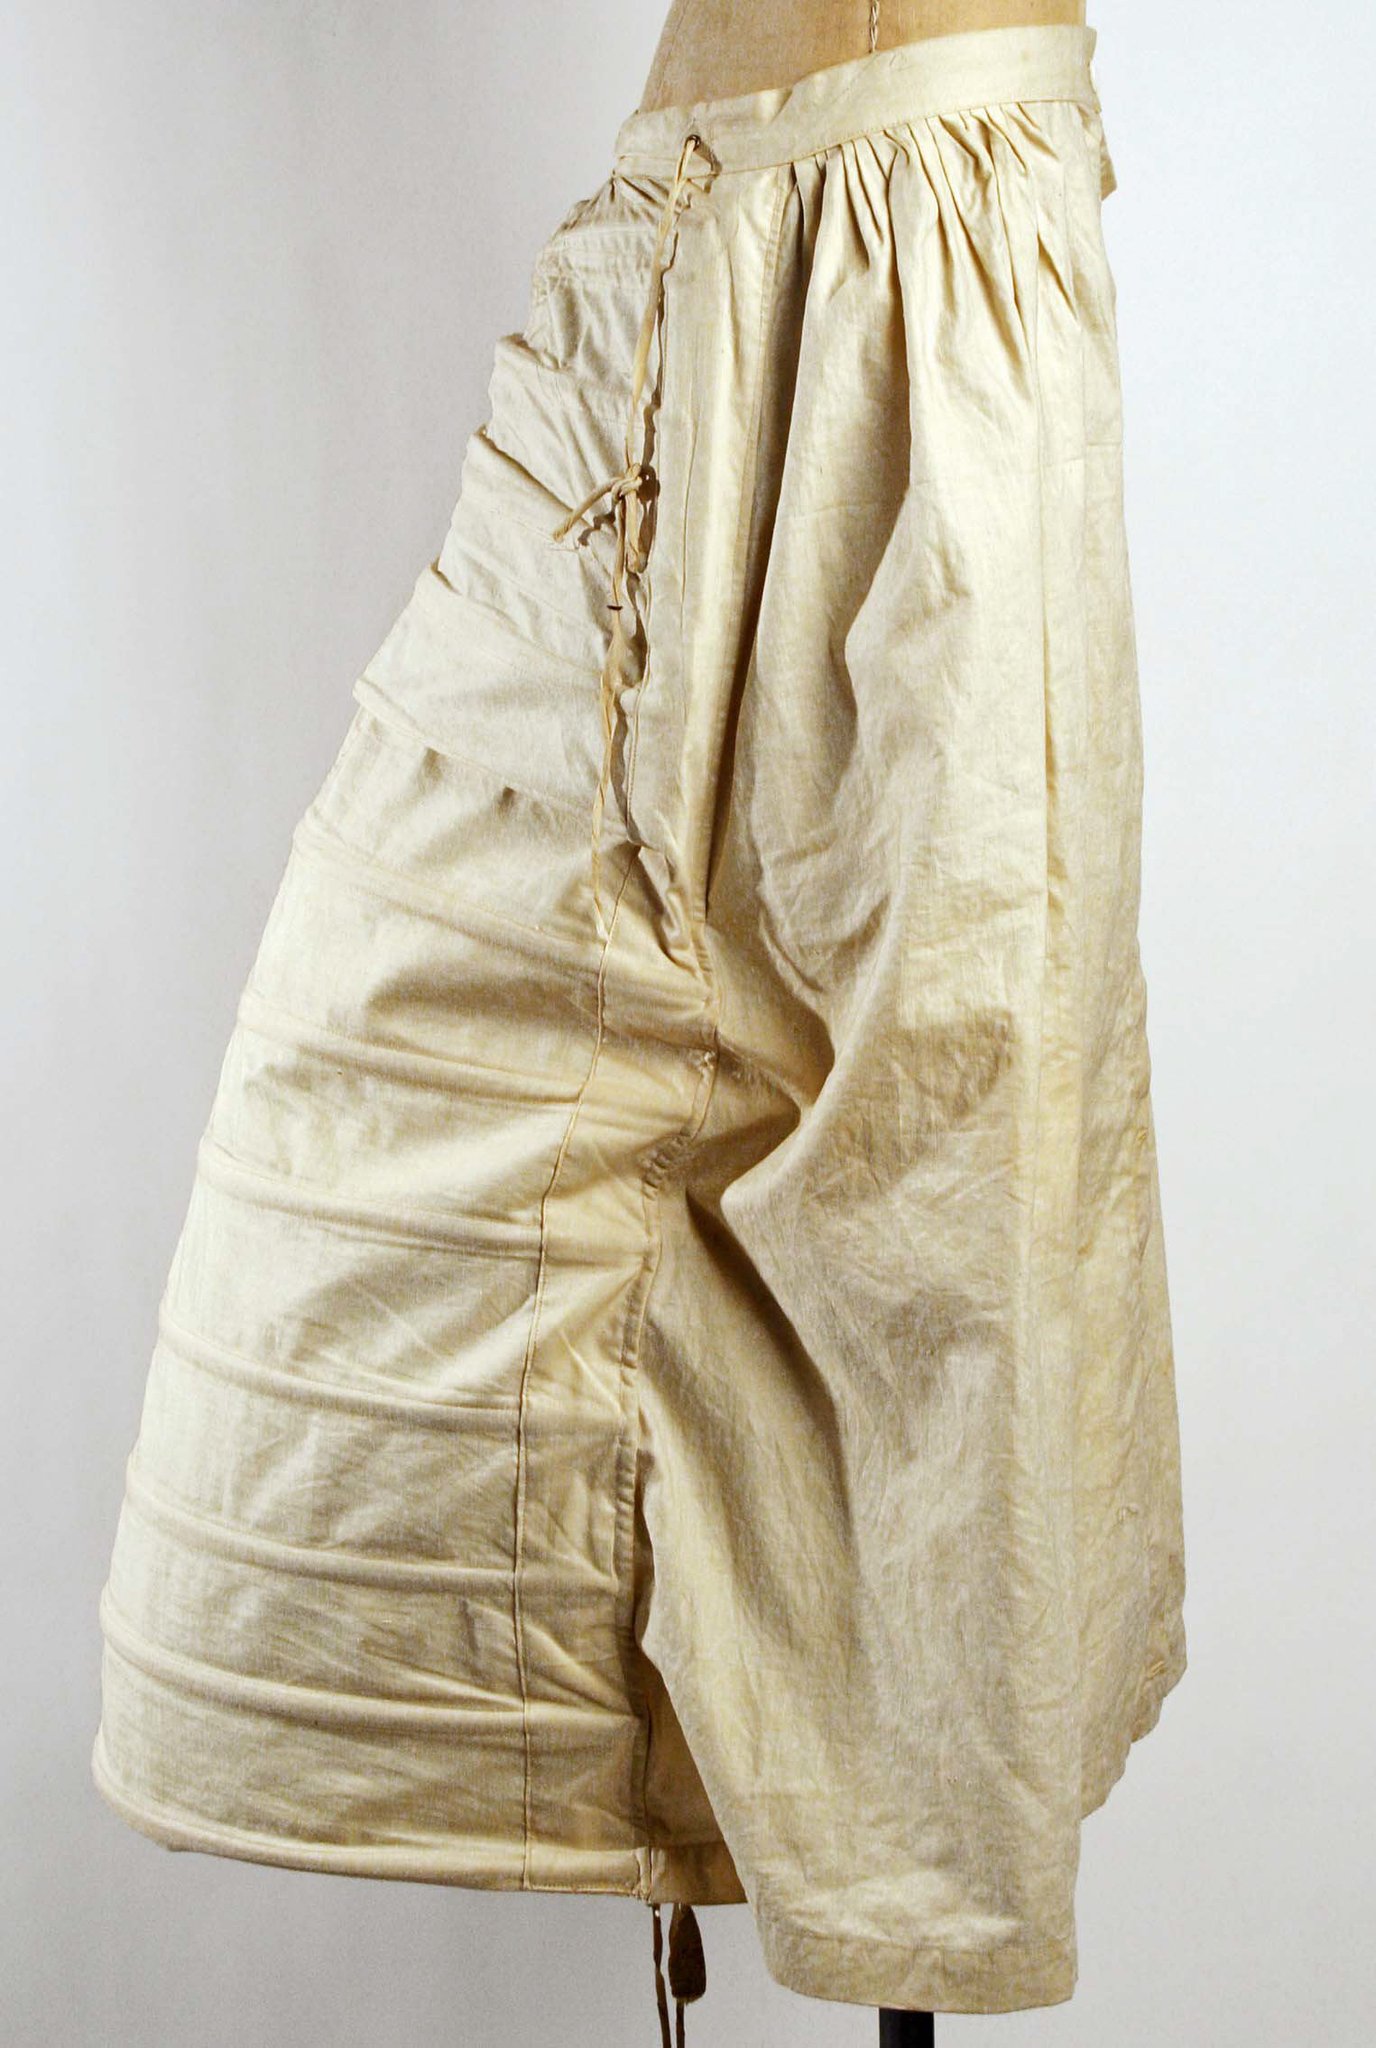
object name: bustle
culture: american or european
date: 1880-1885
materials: cotton